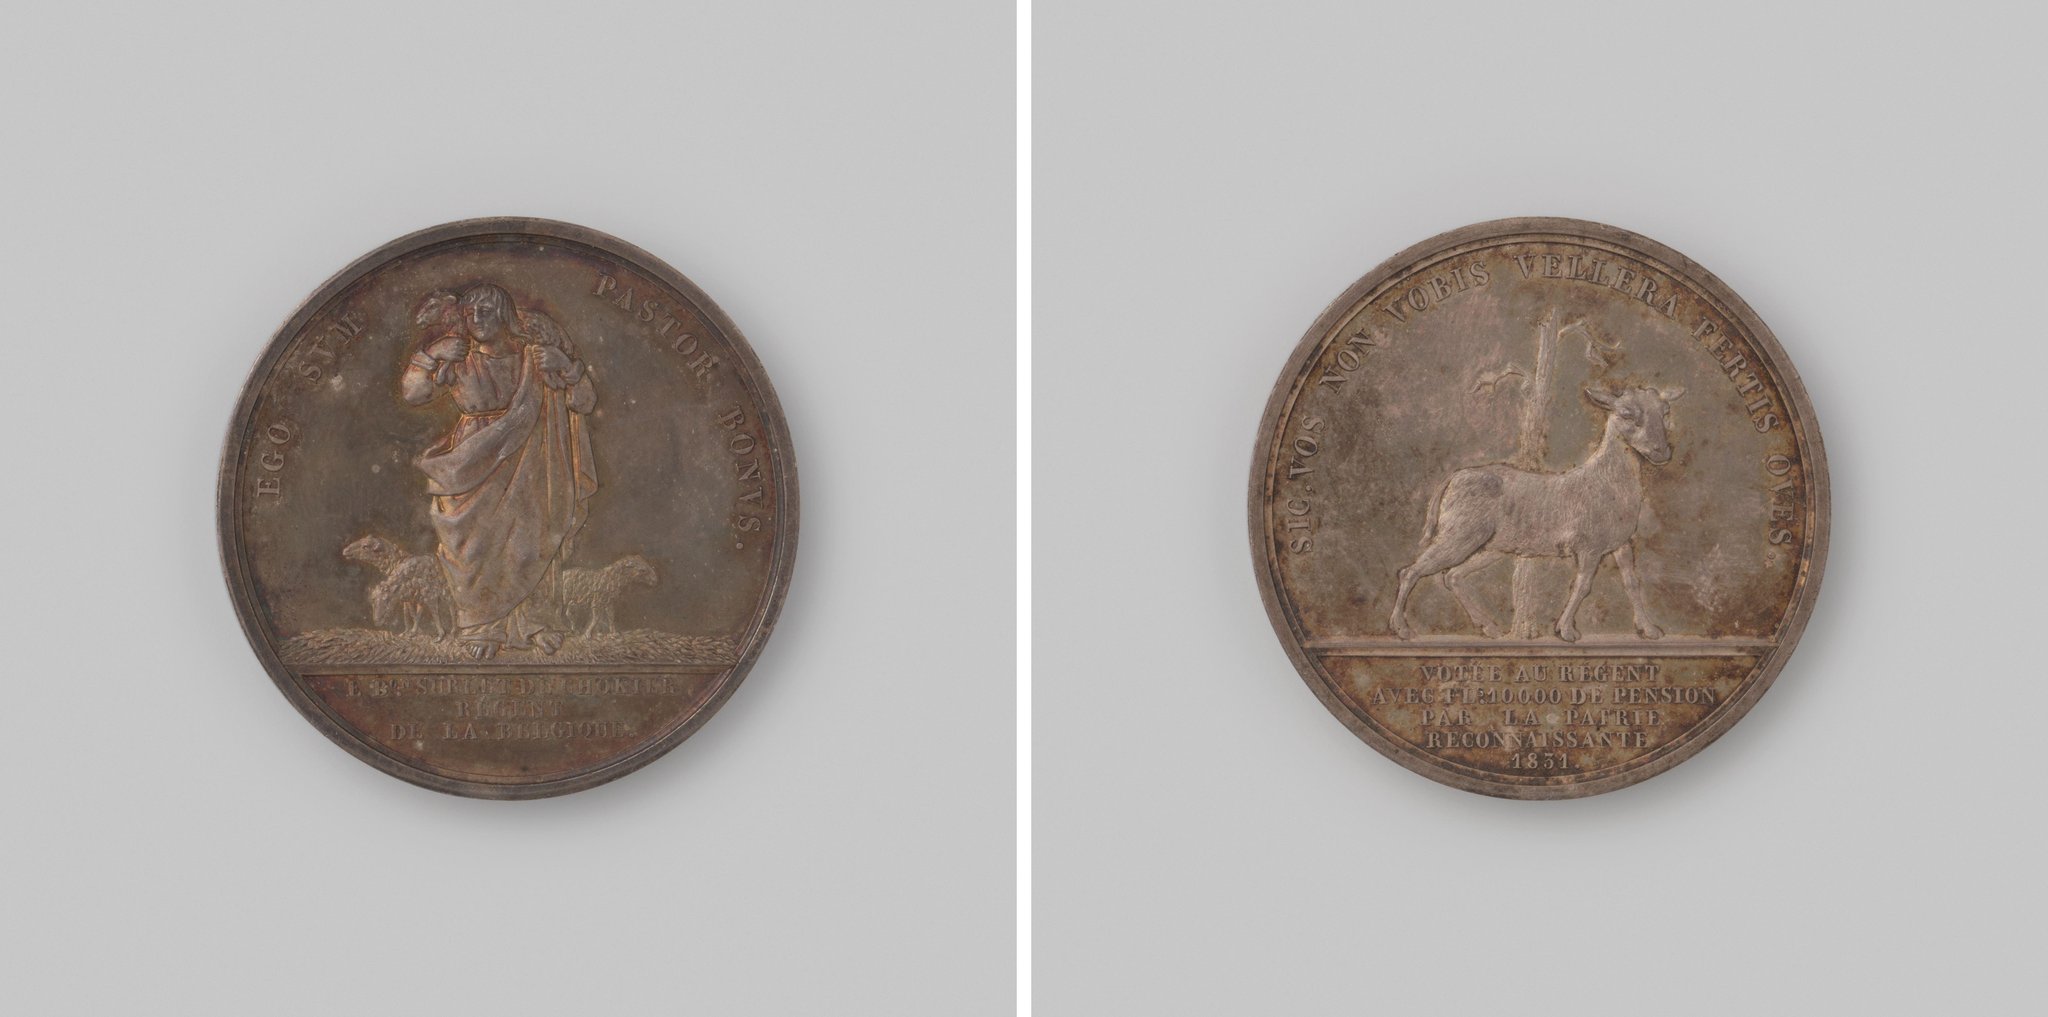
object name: history medal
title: Aftreden van baron Surlet de Chokier als regent van België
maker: Anonymous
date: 1831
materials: silver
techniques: striking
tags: liège